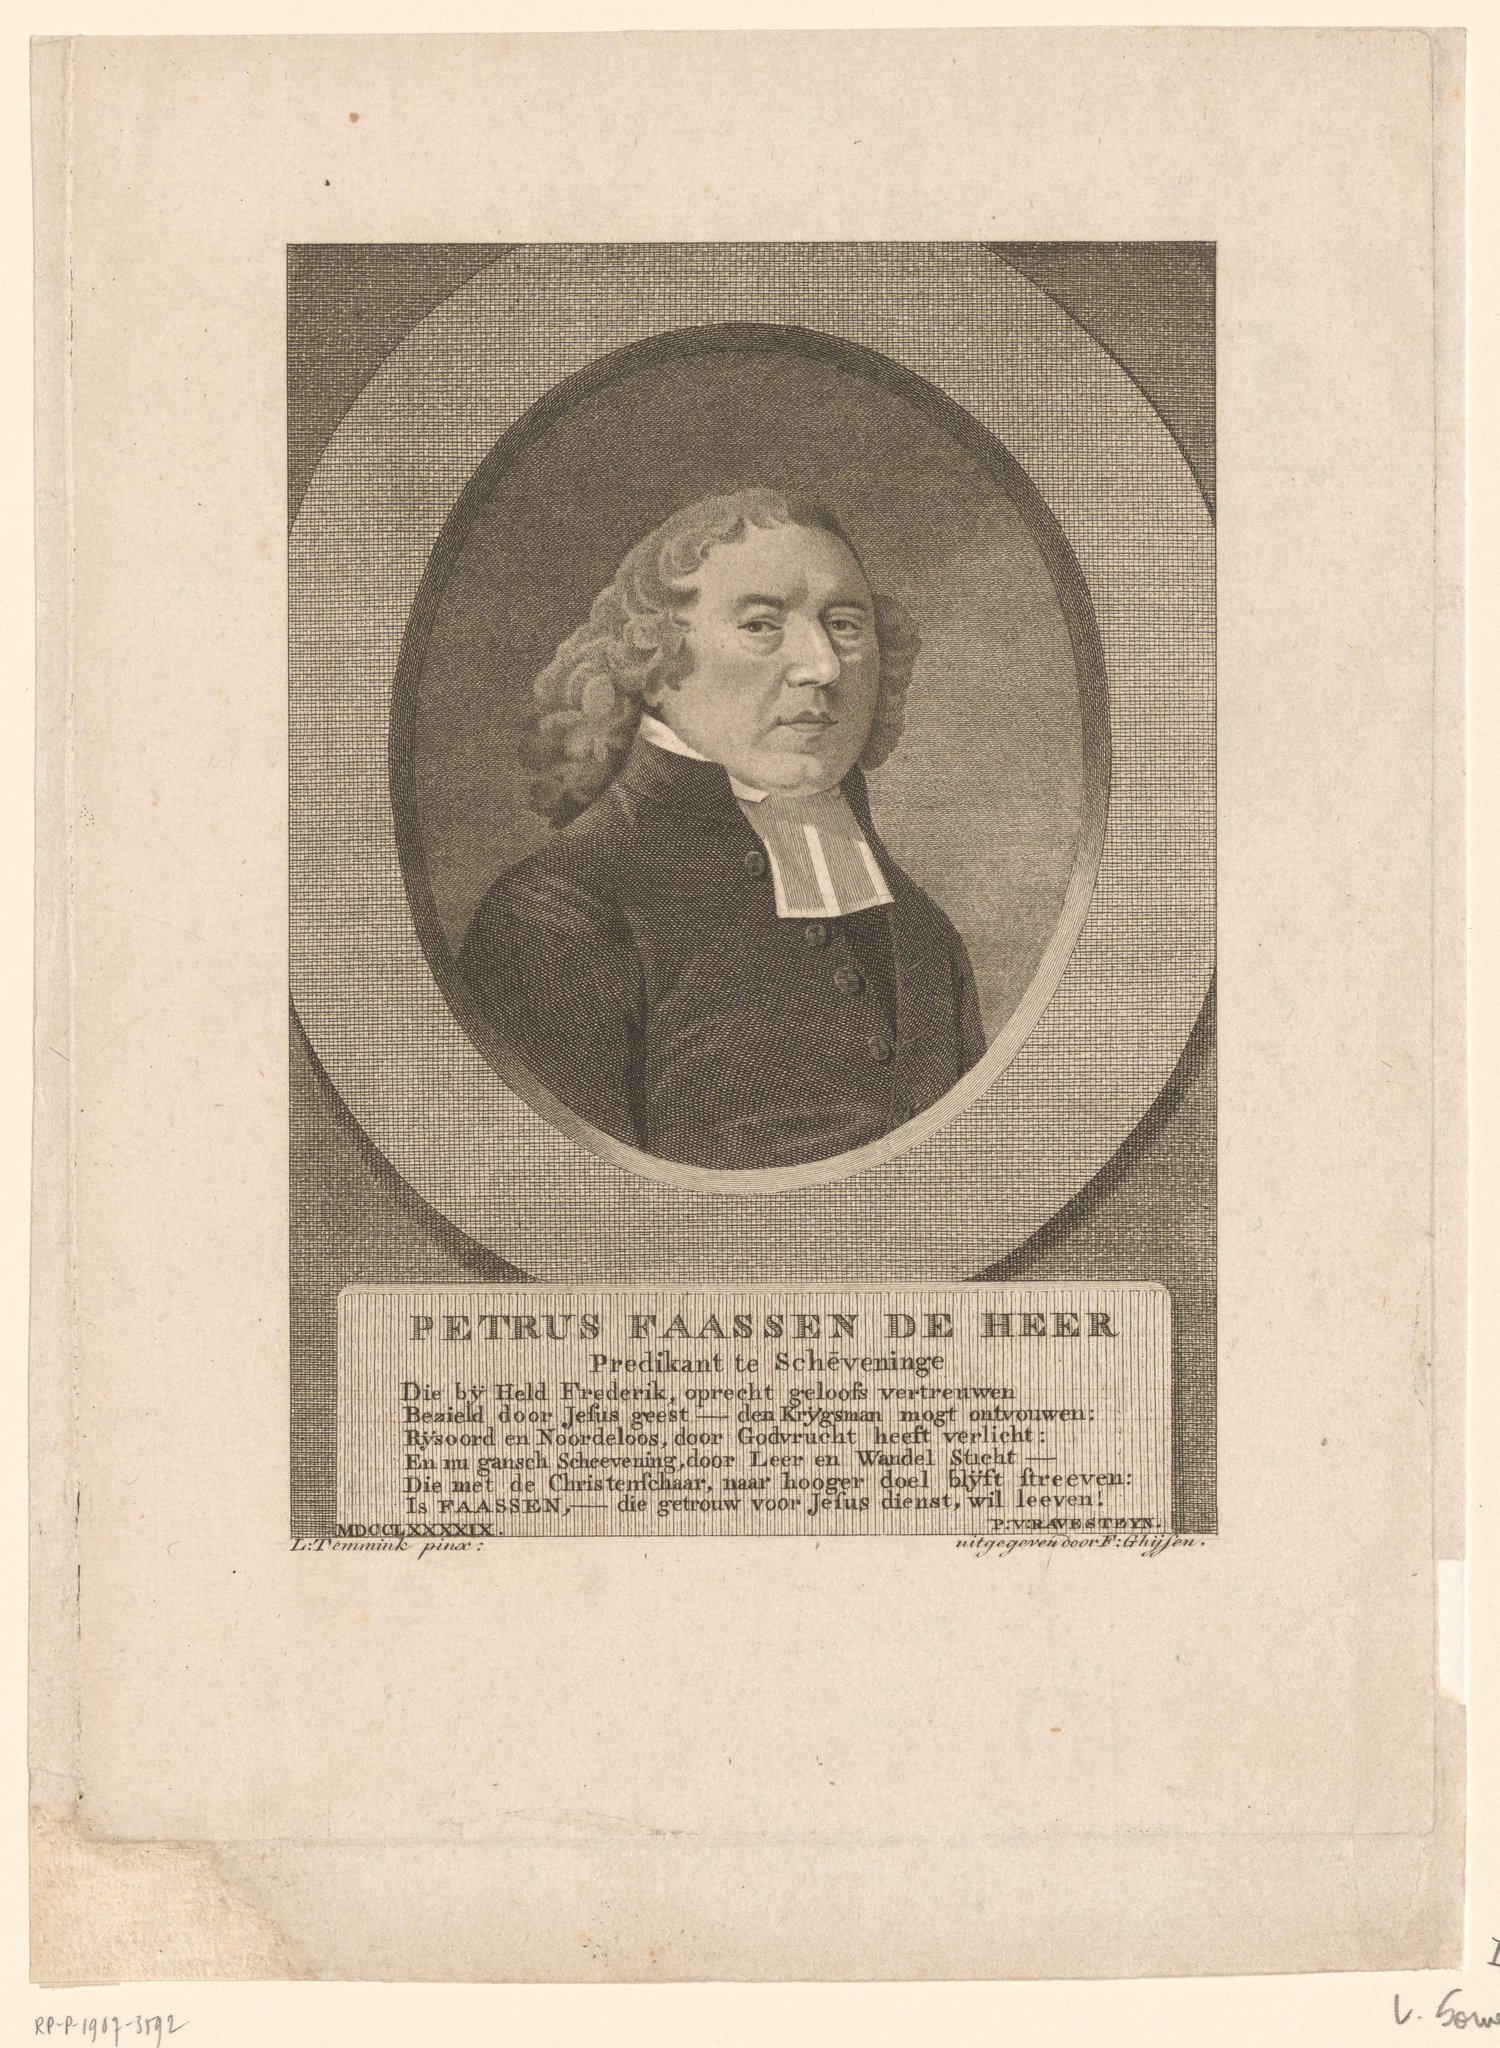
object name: print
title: Portret van Petrus Faassen de Heer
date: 1799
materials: paper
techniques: aquatint, etching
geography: the hague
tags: historical persons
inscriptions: collector's mark: Lugt 2228